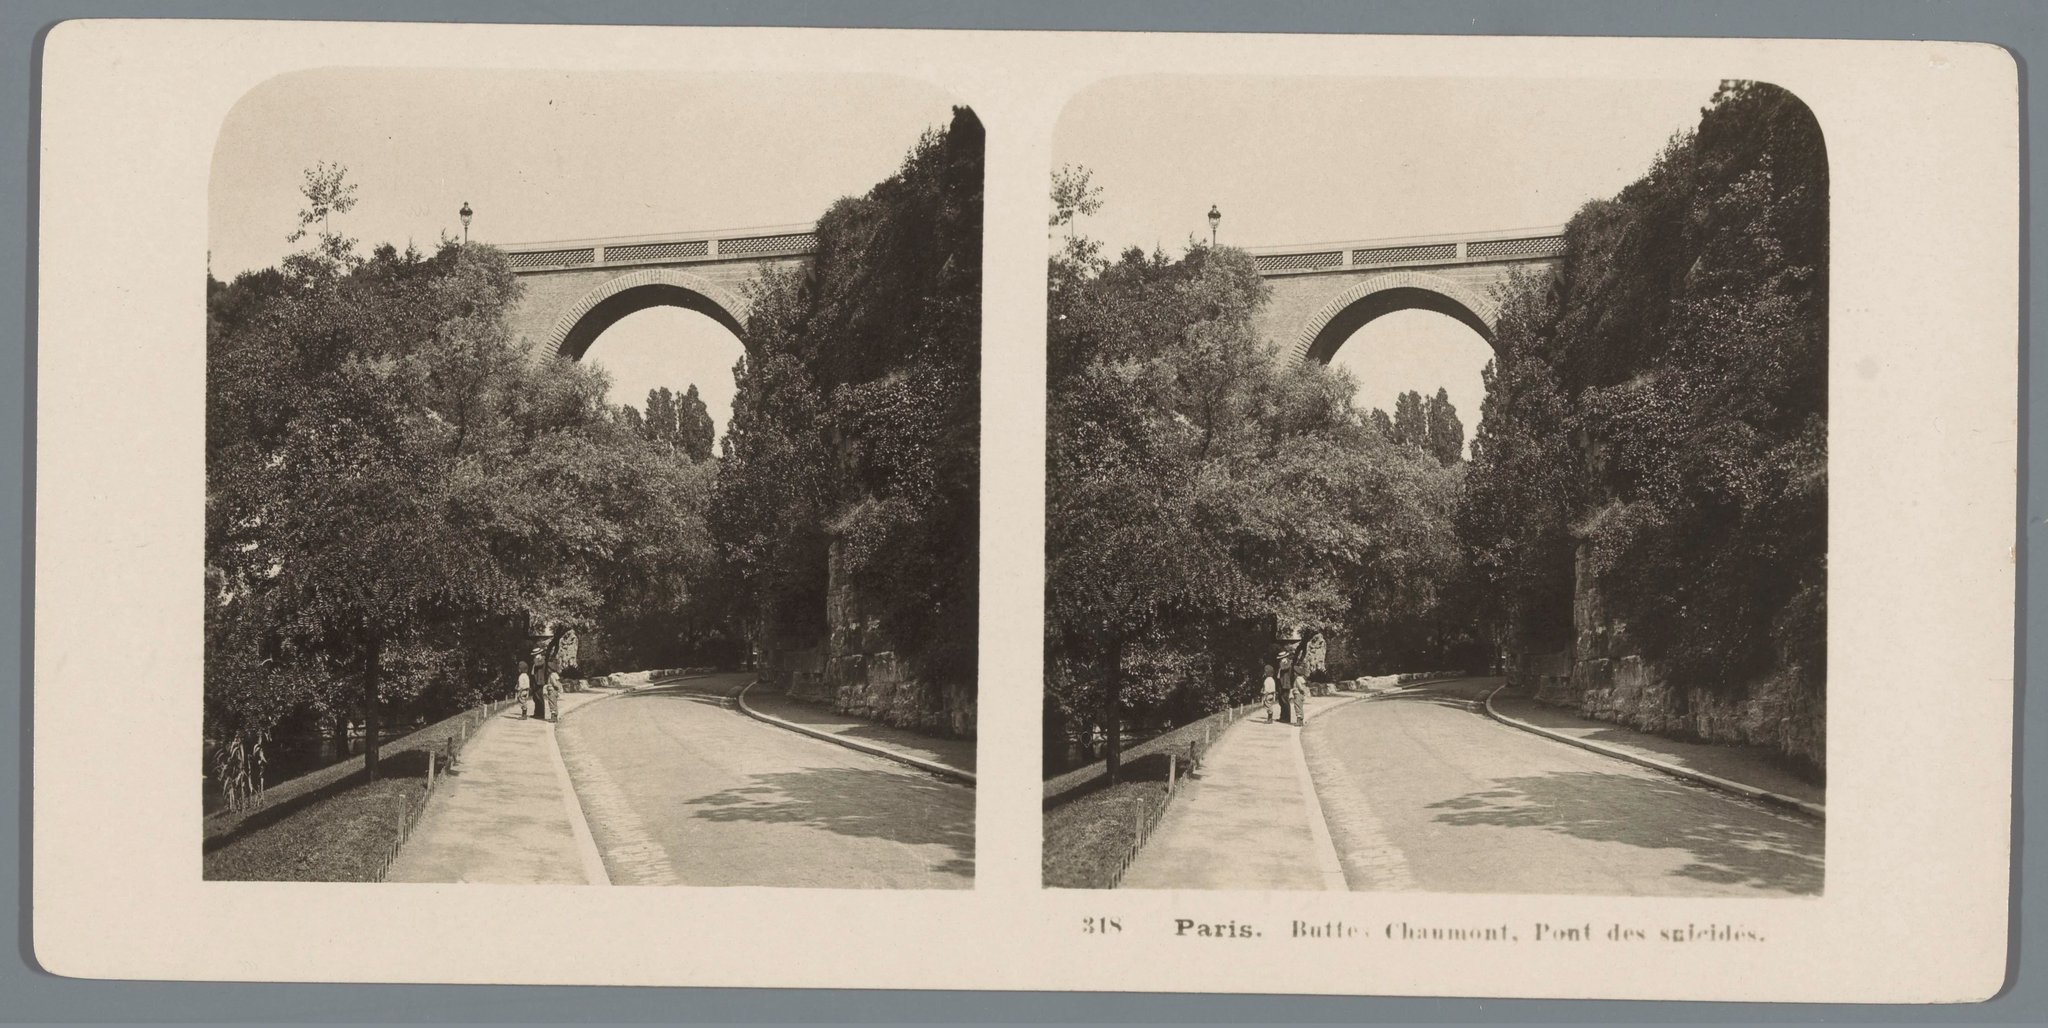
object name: stereograph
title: Paris. Buttes Chaumont, pont des suicides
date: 1904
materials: cardboard, photographic support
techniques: gelatin silver print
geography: parc des buttes-chaumont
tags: road, path, bridge, public gardens, park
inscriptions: inscription: ‘Neue Photographische Gesellschaft A.-G. Steglitz-Berlin 1904.’, number: ‘318’